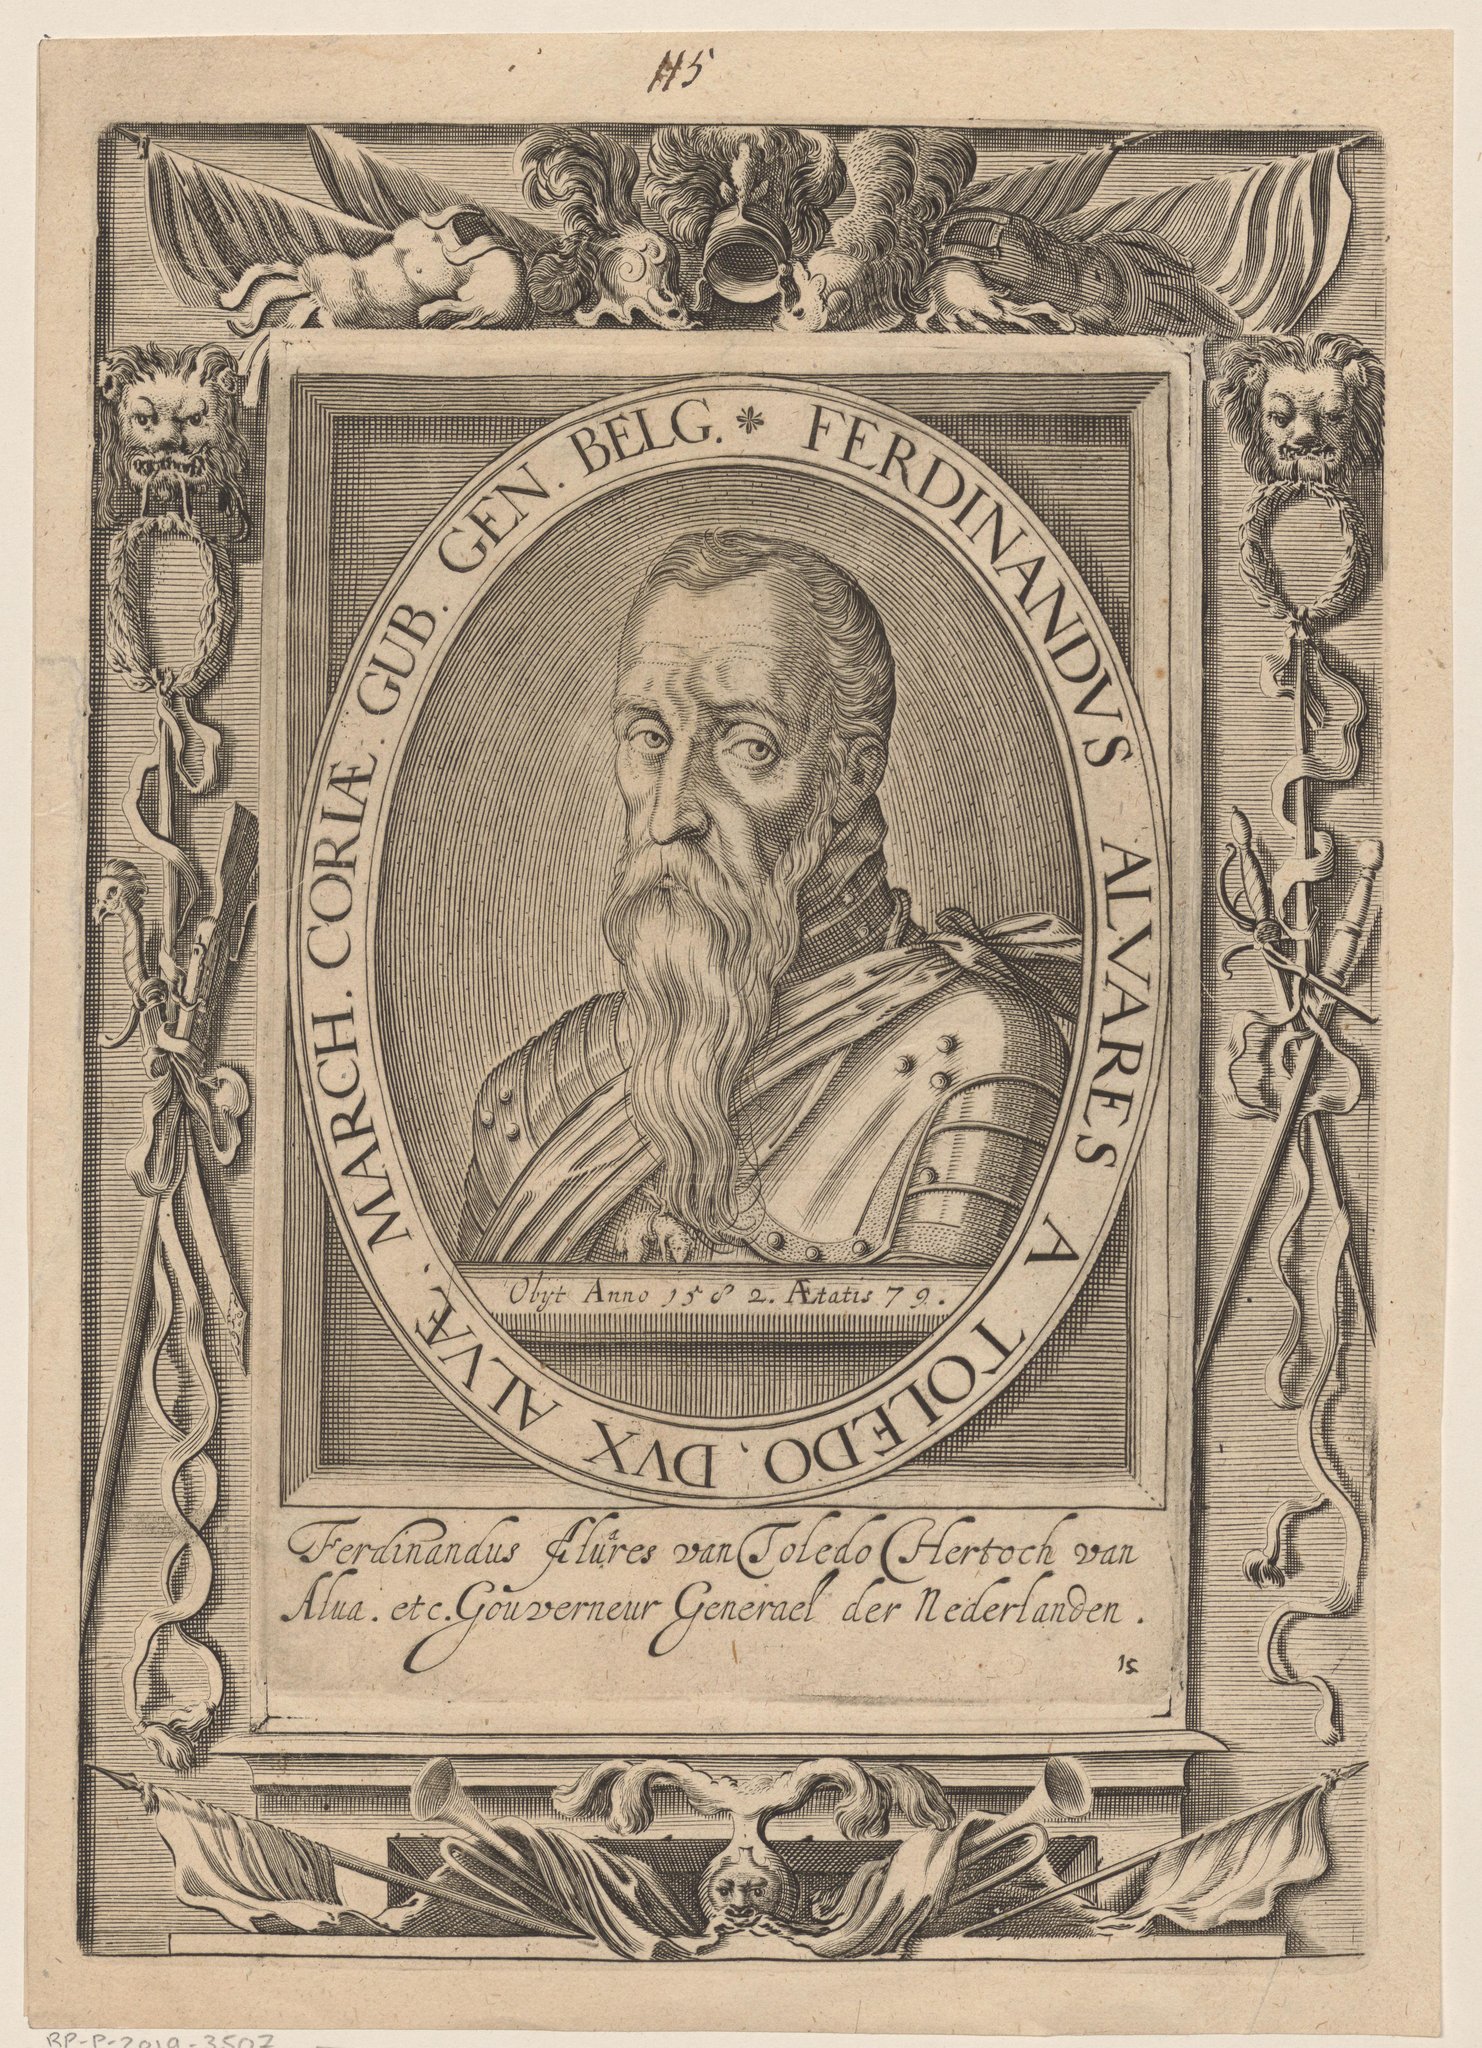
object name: print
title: Portret van Fernando Álvarez de Toledo, hertog van Alva, op 79-jarige leeftijd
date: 1640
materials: paper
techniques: engraving, etching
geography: amsterdam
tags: fernando álvarez de toledo (3rd duke of alba), armour, historical persons, flags (~ signalling), knighthood order of the golden fleece - insignia of a knighthood order, e.g.: badge, chain (with name of order)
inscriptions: inscription: ‘115’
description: Prent uit: Meteren, Emanuel van. Niderlandische Historien. Amsterdam: Johannes Janssonius, 1640. Portret zonder rand ook verschenen in eerdere edities van Van Meterens Historiën.